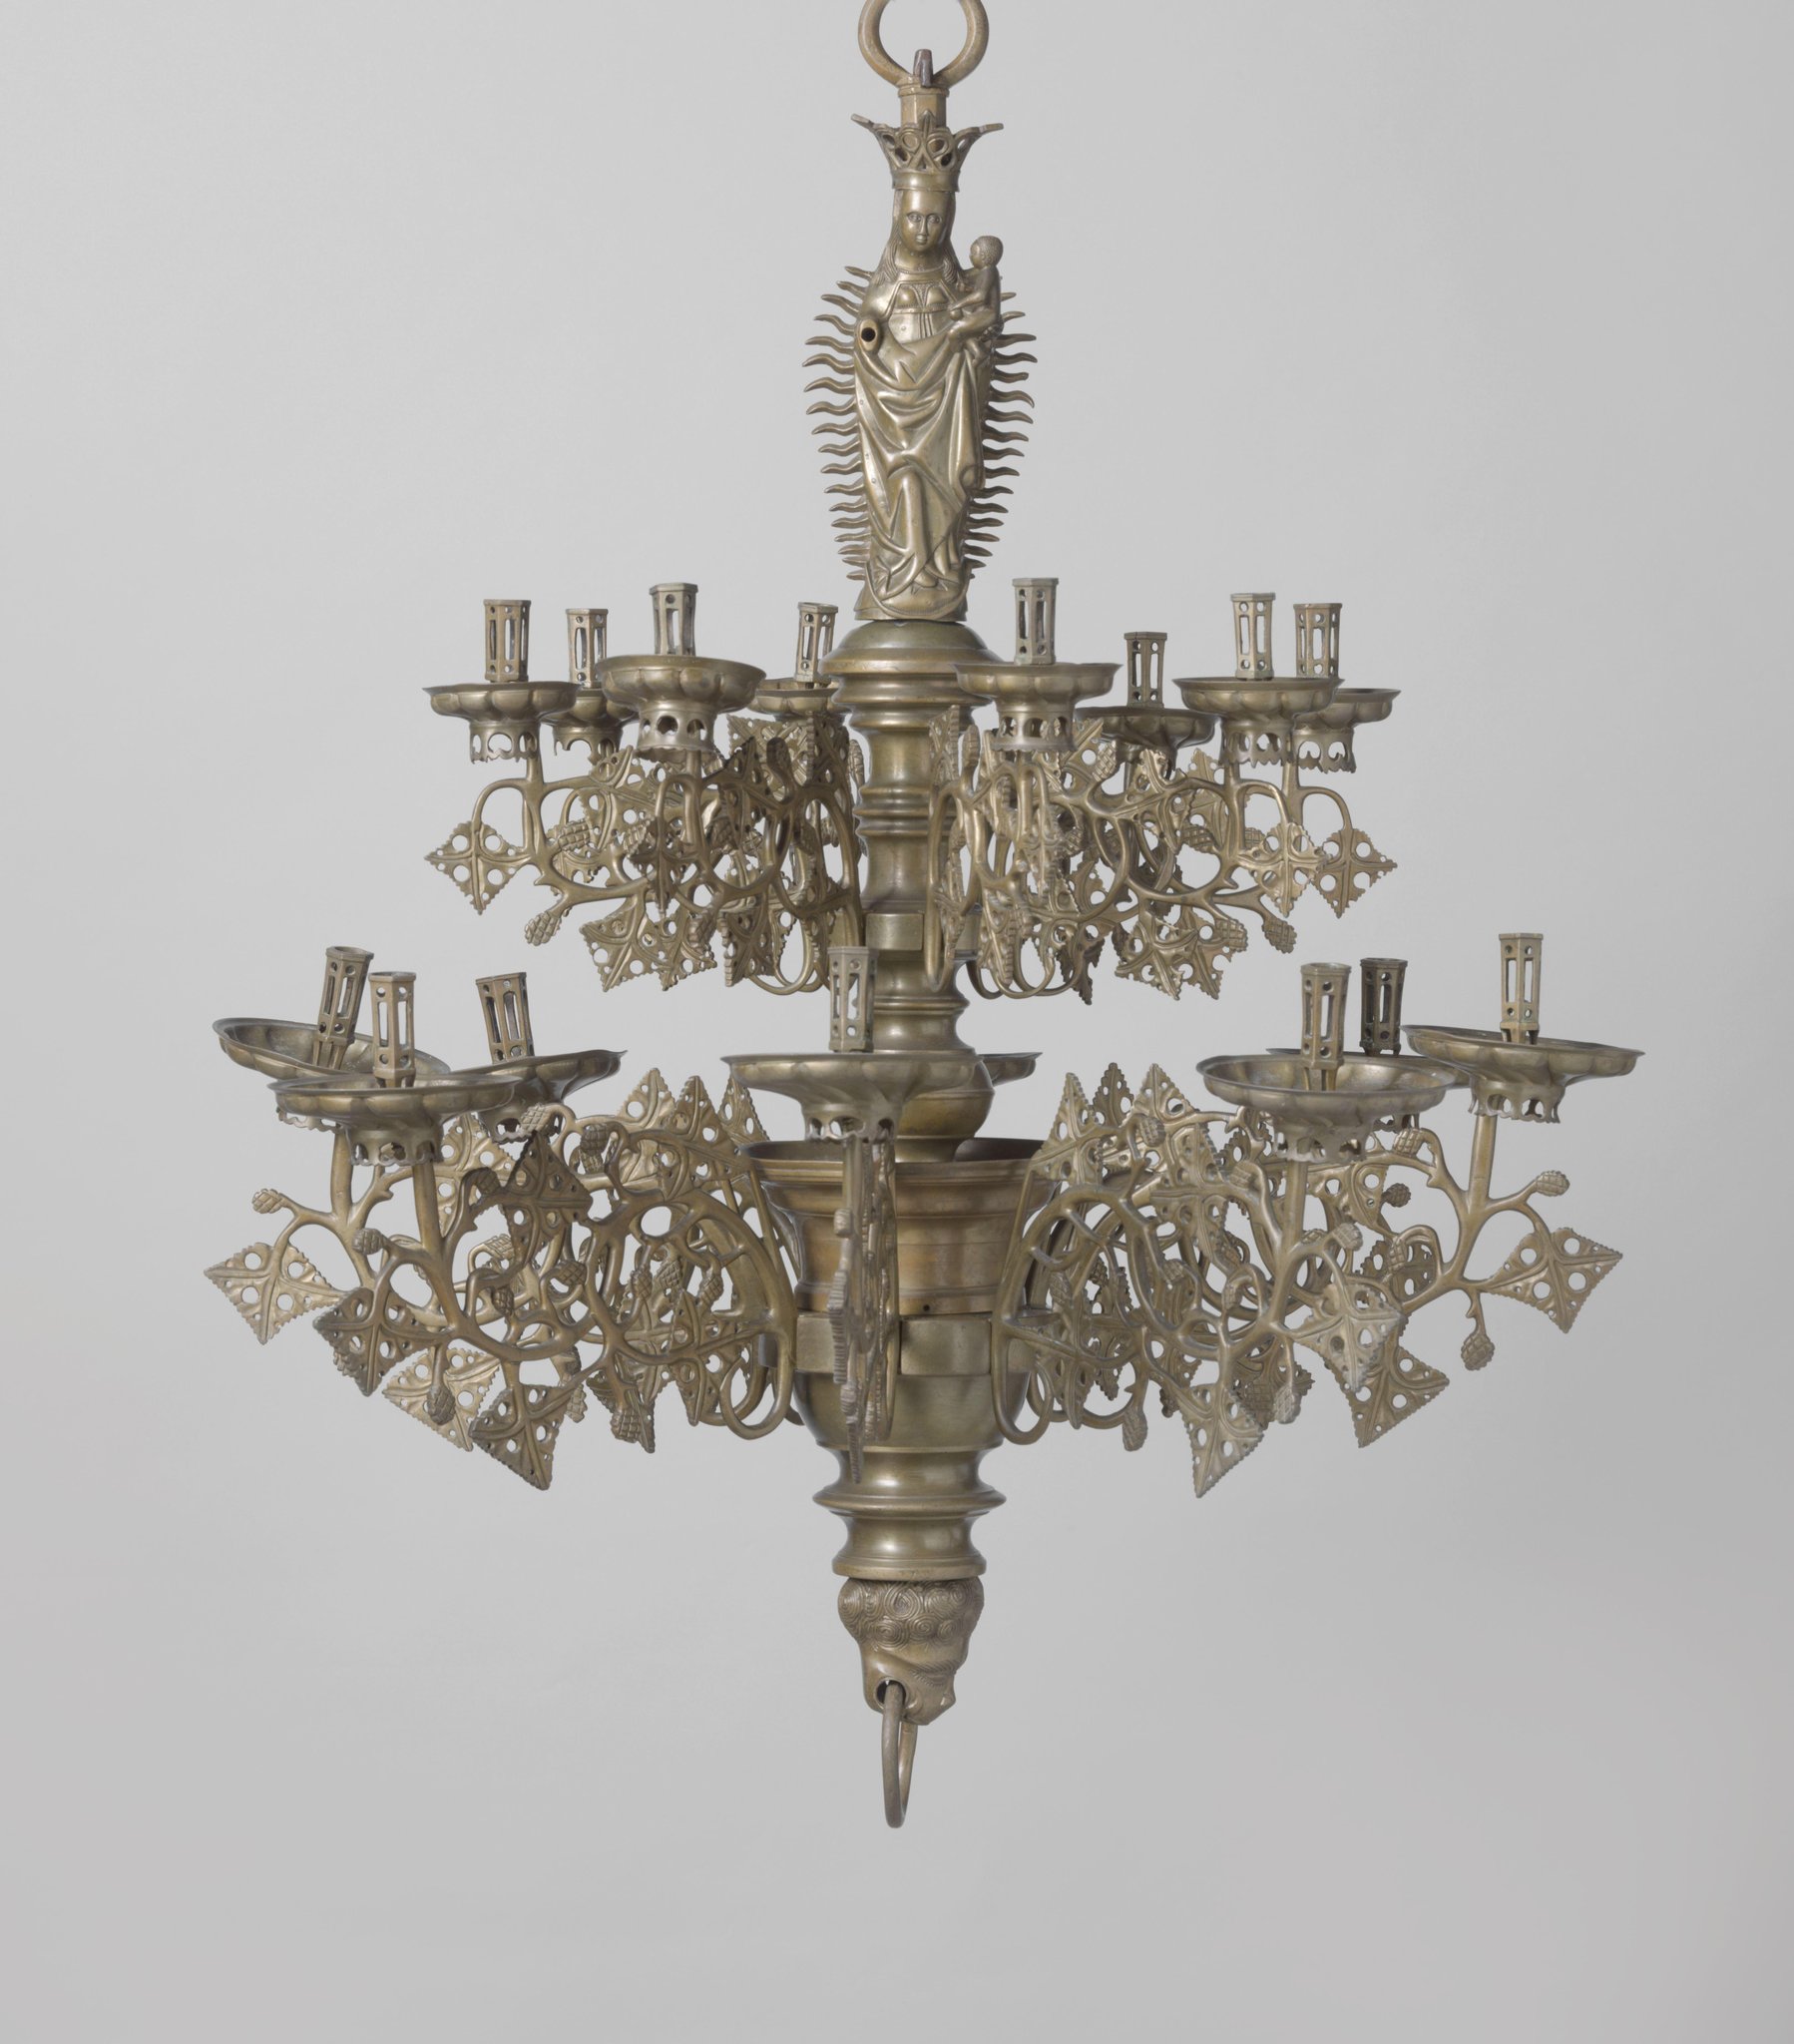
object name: chandelier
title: Arm met kaarsenhouder van kaarsenkroon van twee hoogten met ieder acht armen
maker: Anonymous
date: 1525-1550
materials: brass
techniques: casting, screwed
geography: southern netherlands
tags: vine-tendril, leaf, mary standing (or half-length), the christ-child sitting on her arm (christ-child to mary's left)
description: Kaarsenarm behorende bij een kaarsenkroon van twee hoogten met Mariafiguur bovenaan. De arm is twee maal gebogen en is versierd met vier druiventrossen en vijf wingerdbladeren. De ronde vetvanger is aan de onderkant versierd met visblaasmotieven en heeft naar het midden toe een naar beneden uitstekende rand van kruisbloemen, die de plaatsing op de arm maskeert. De kaarsenhouder is zesvlakkig, opengewerkt, geplaatst op drie verticale stijlen, overgaande in een uitsteeksel met schroefdraad. Dit is de zevende arm van de bovenste ring, genummerd met 7 ronde punten. De kaarsenhouder is ongenummerd.